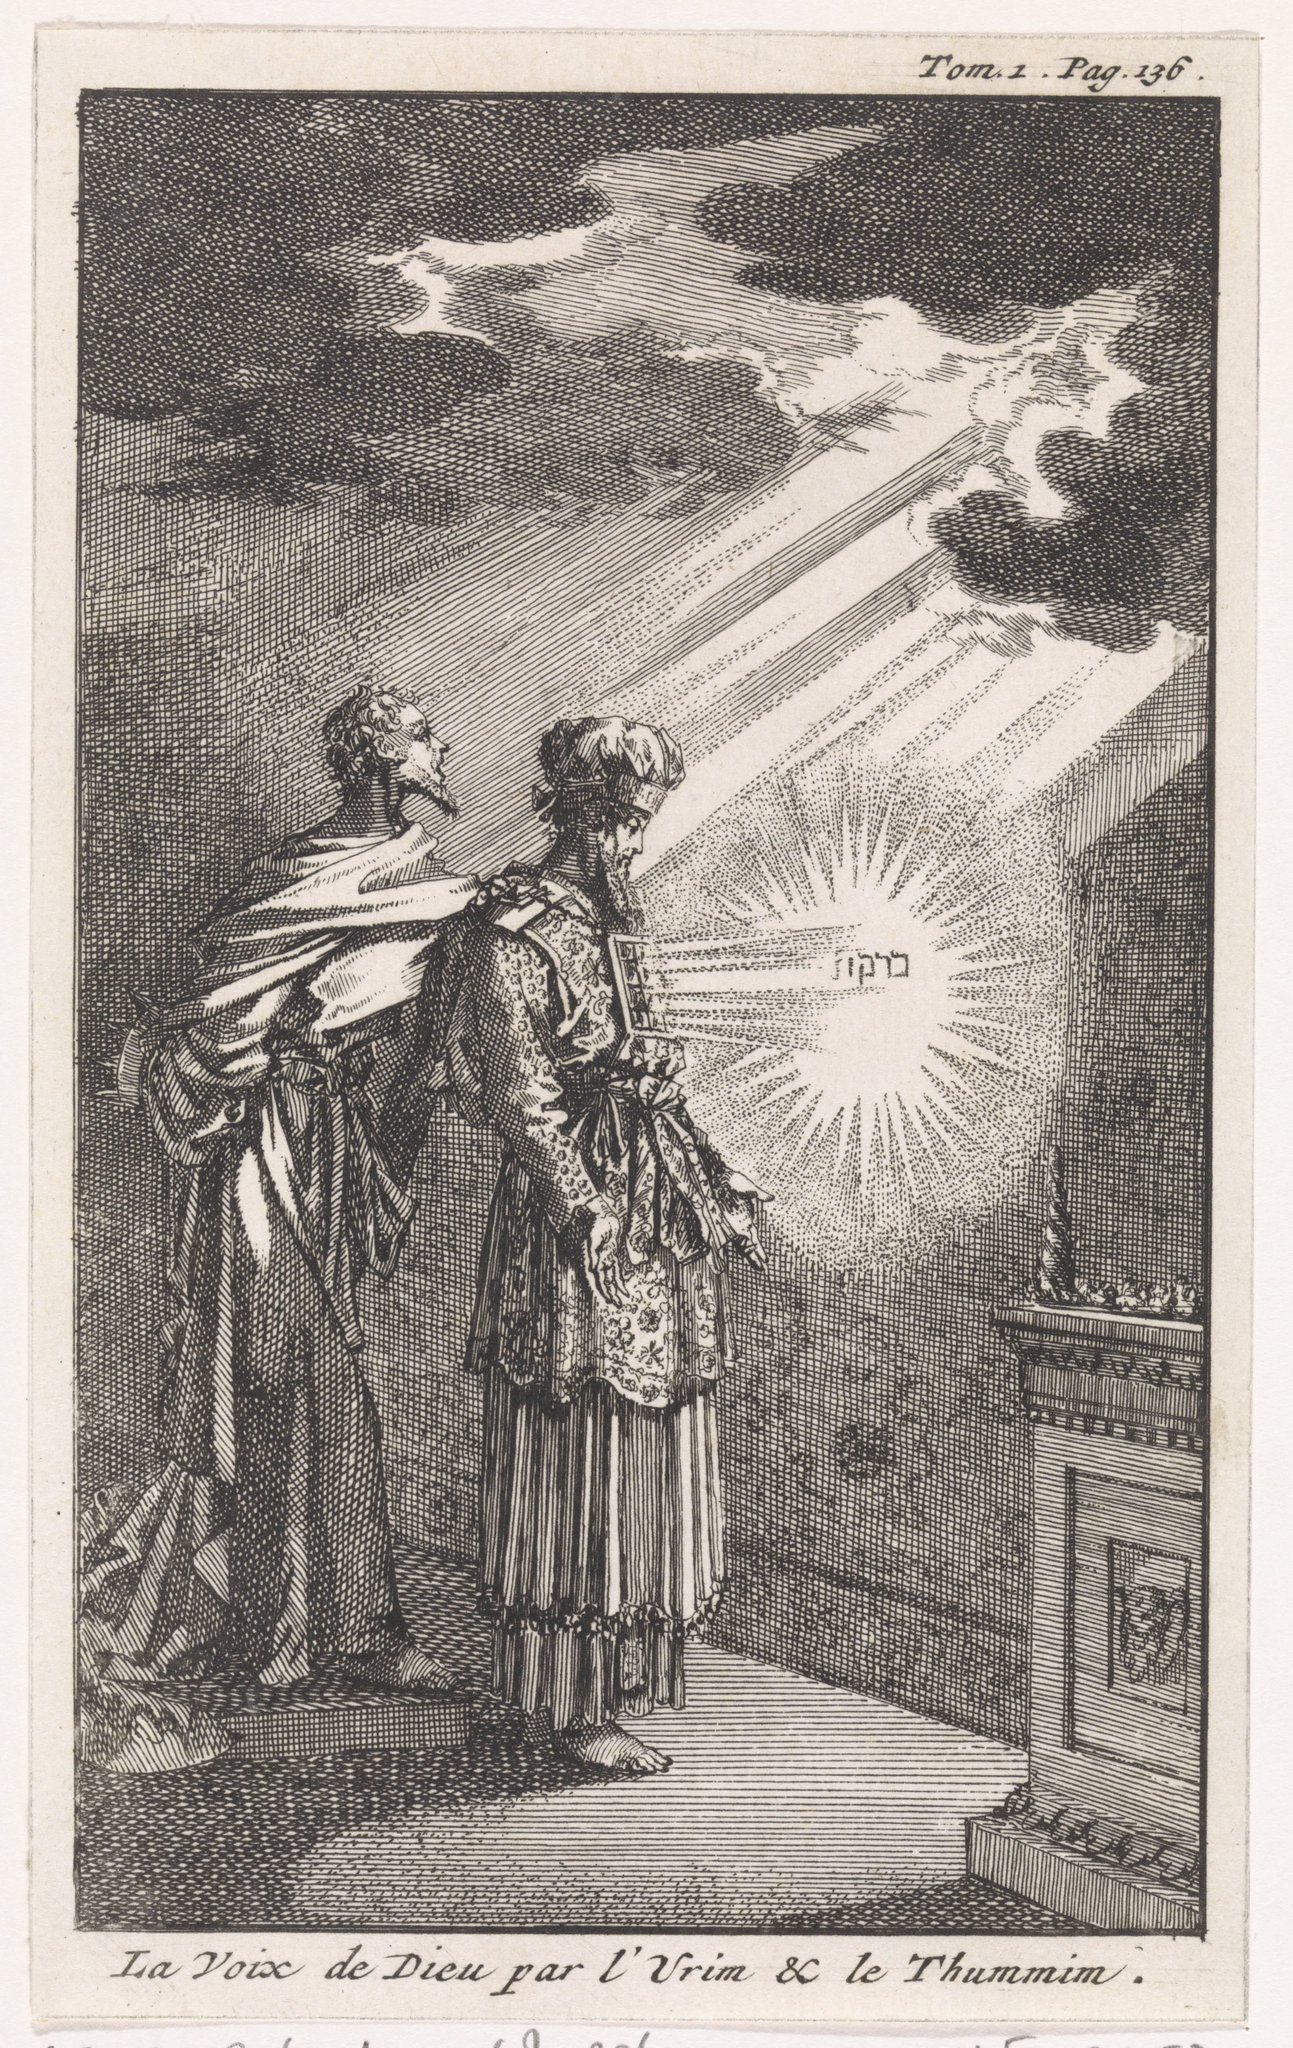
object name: book illustration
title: Godspraak door de Urim en de Thummim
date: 1705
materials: paper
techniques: etching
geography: amsterdam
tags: 'urim' and 'thummim' ~ vestments of high priest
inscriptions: collector's mark: Lugt 2228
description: Illustratie uit: Cunaeus, Petrus. La republique des Hebreux, 3 delen. Amsterdam: Pieter Mortier, 1705, dl. I, p. 136.